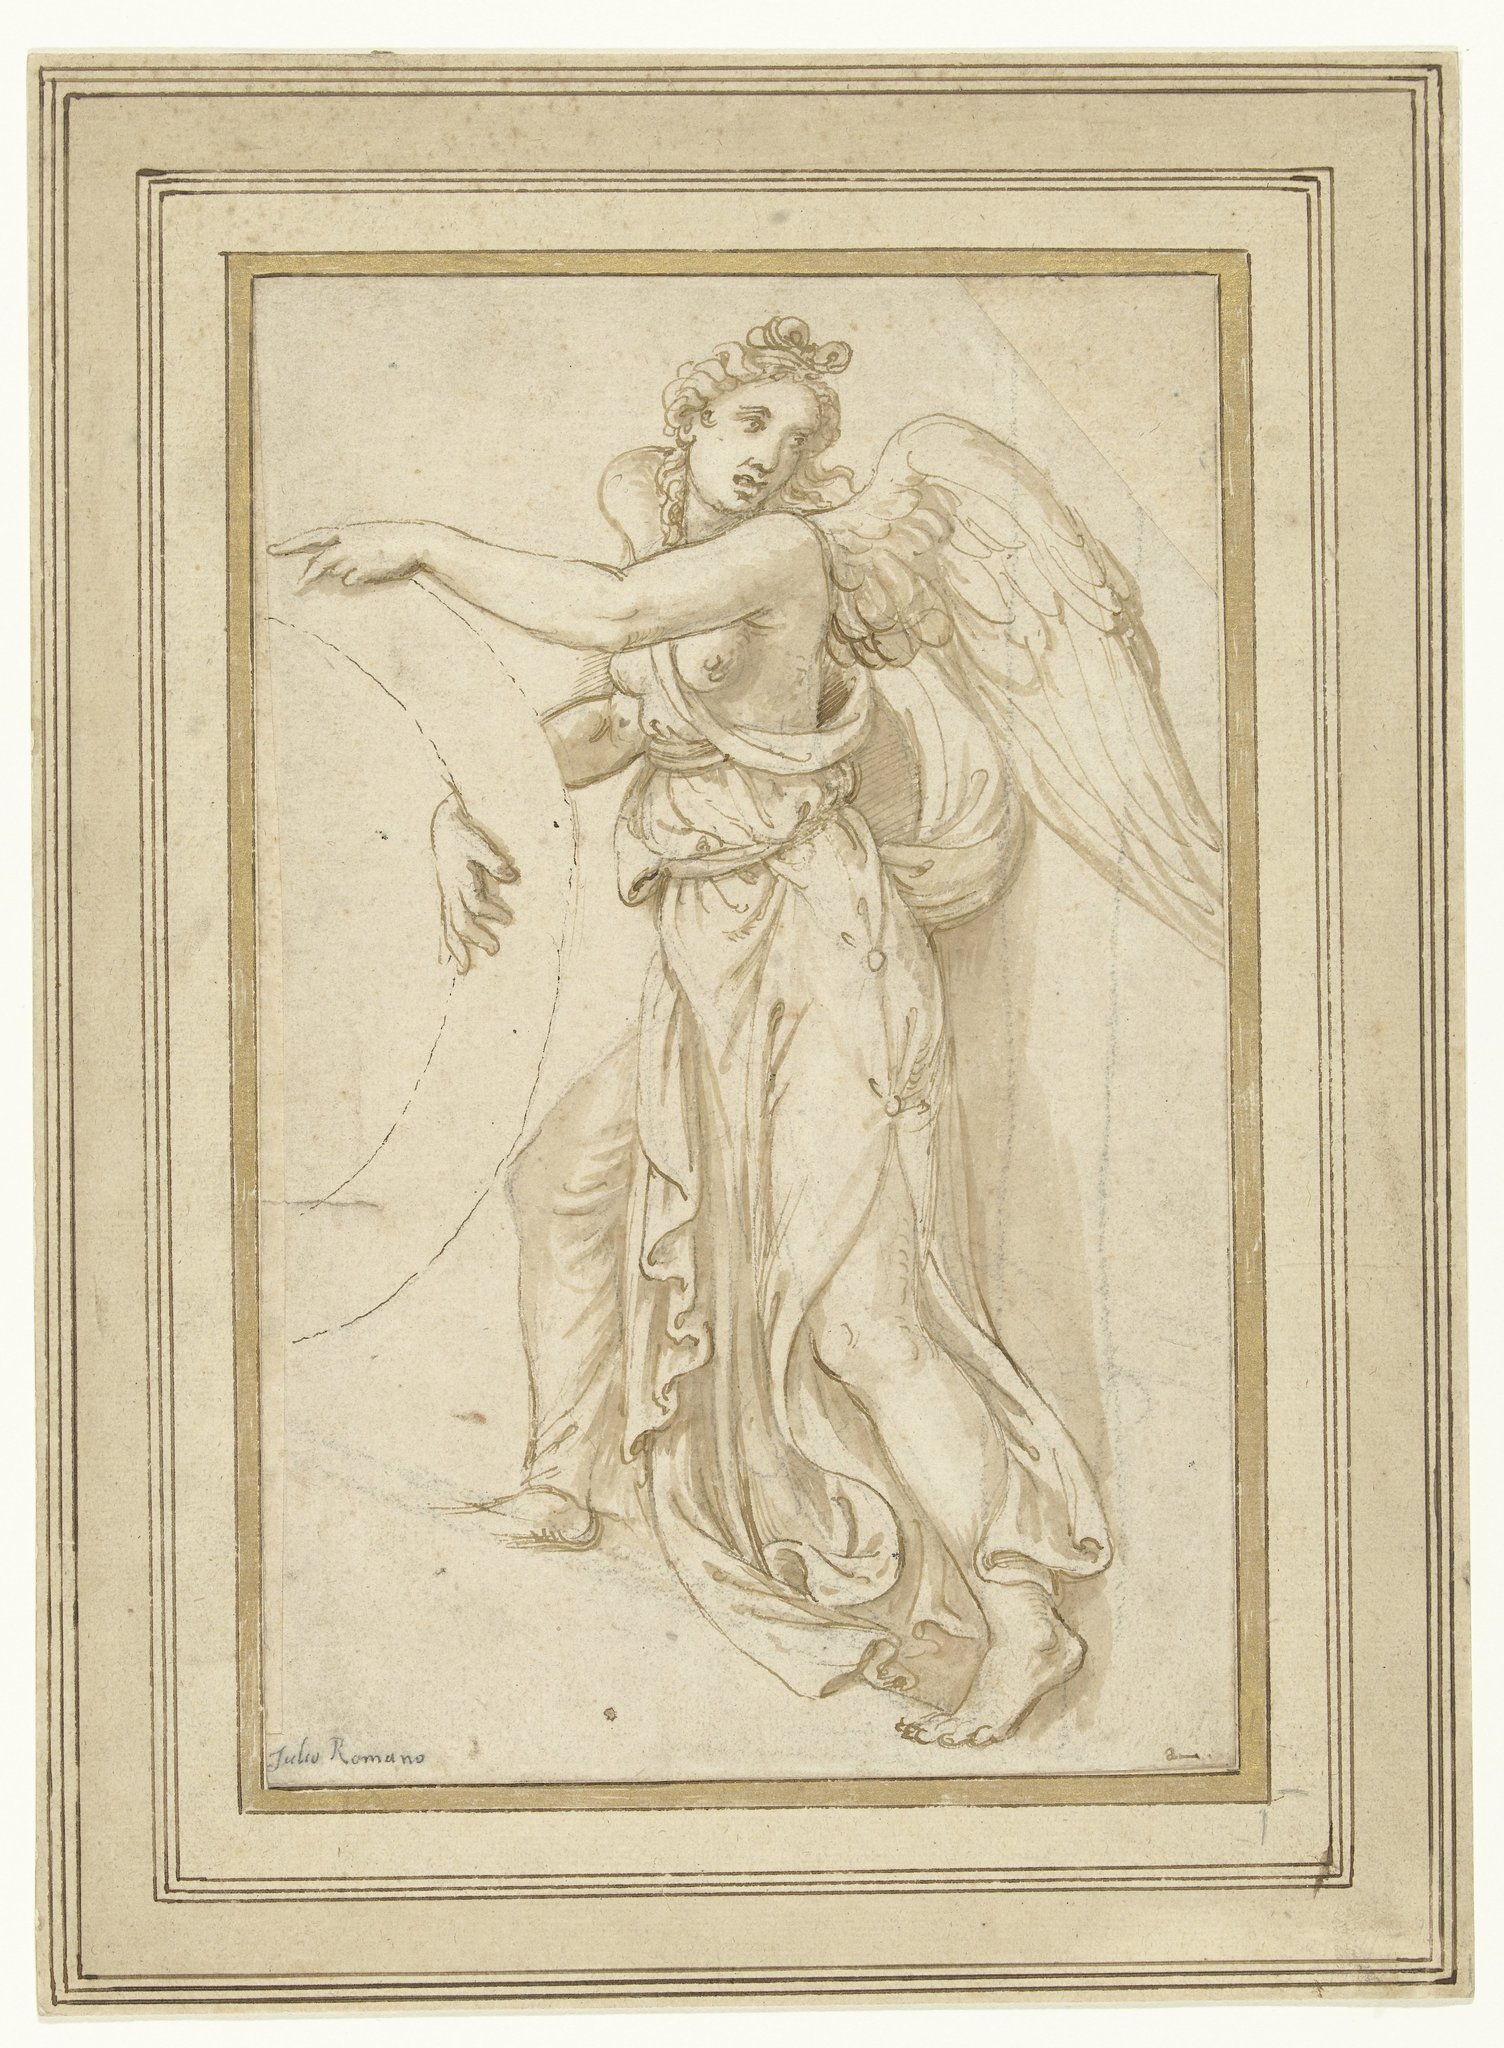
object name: drawing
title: Staande Victoria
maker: giulio romano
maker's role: draughtsman, painter, print maker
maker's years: 1499-1546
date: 1525-1535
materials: chalk, ink, paper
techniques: brush, pen